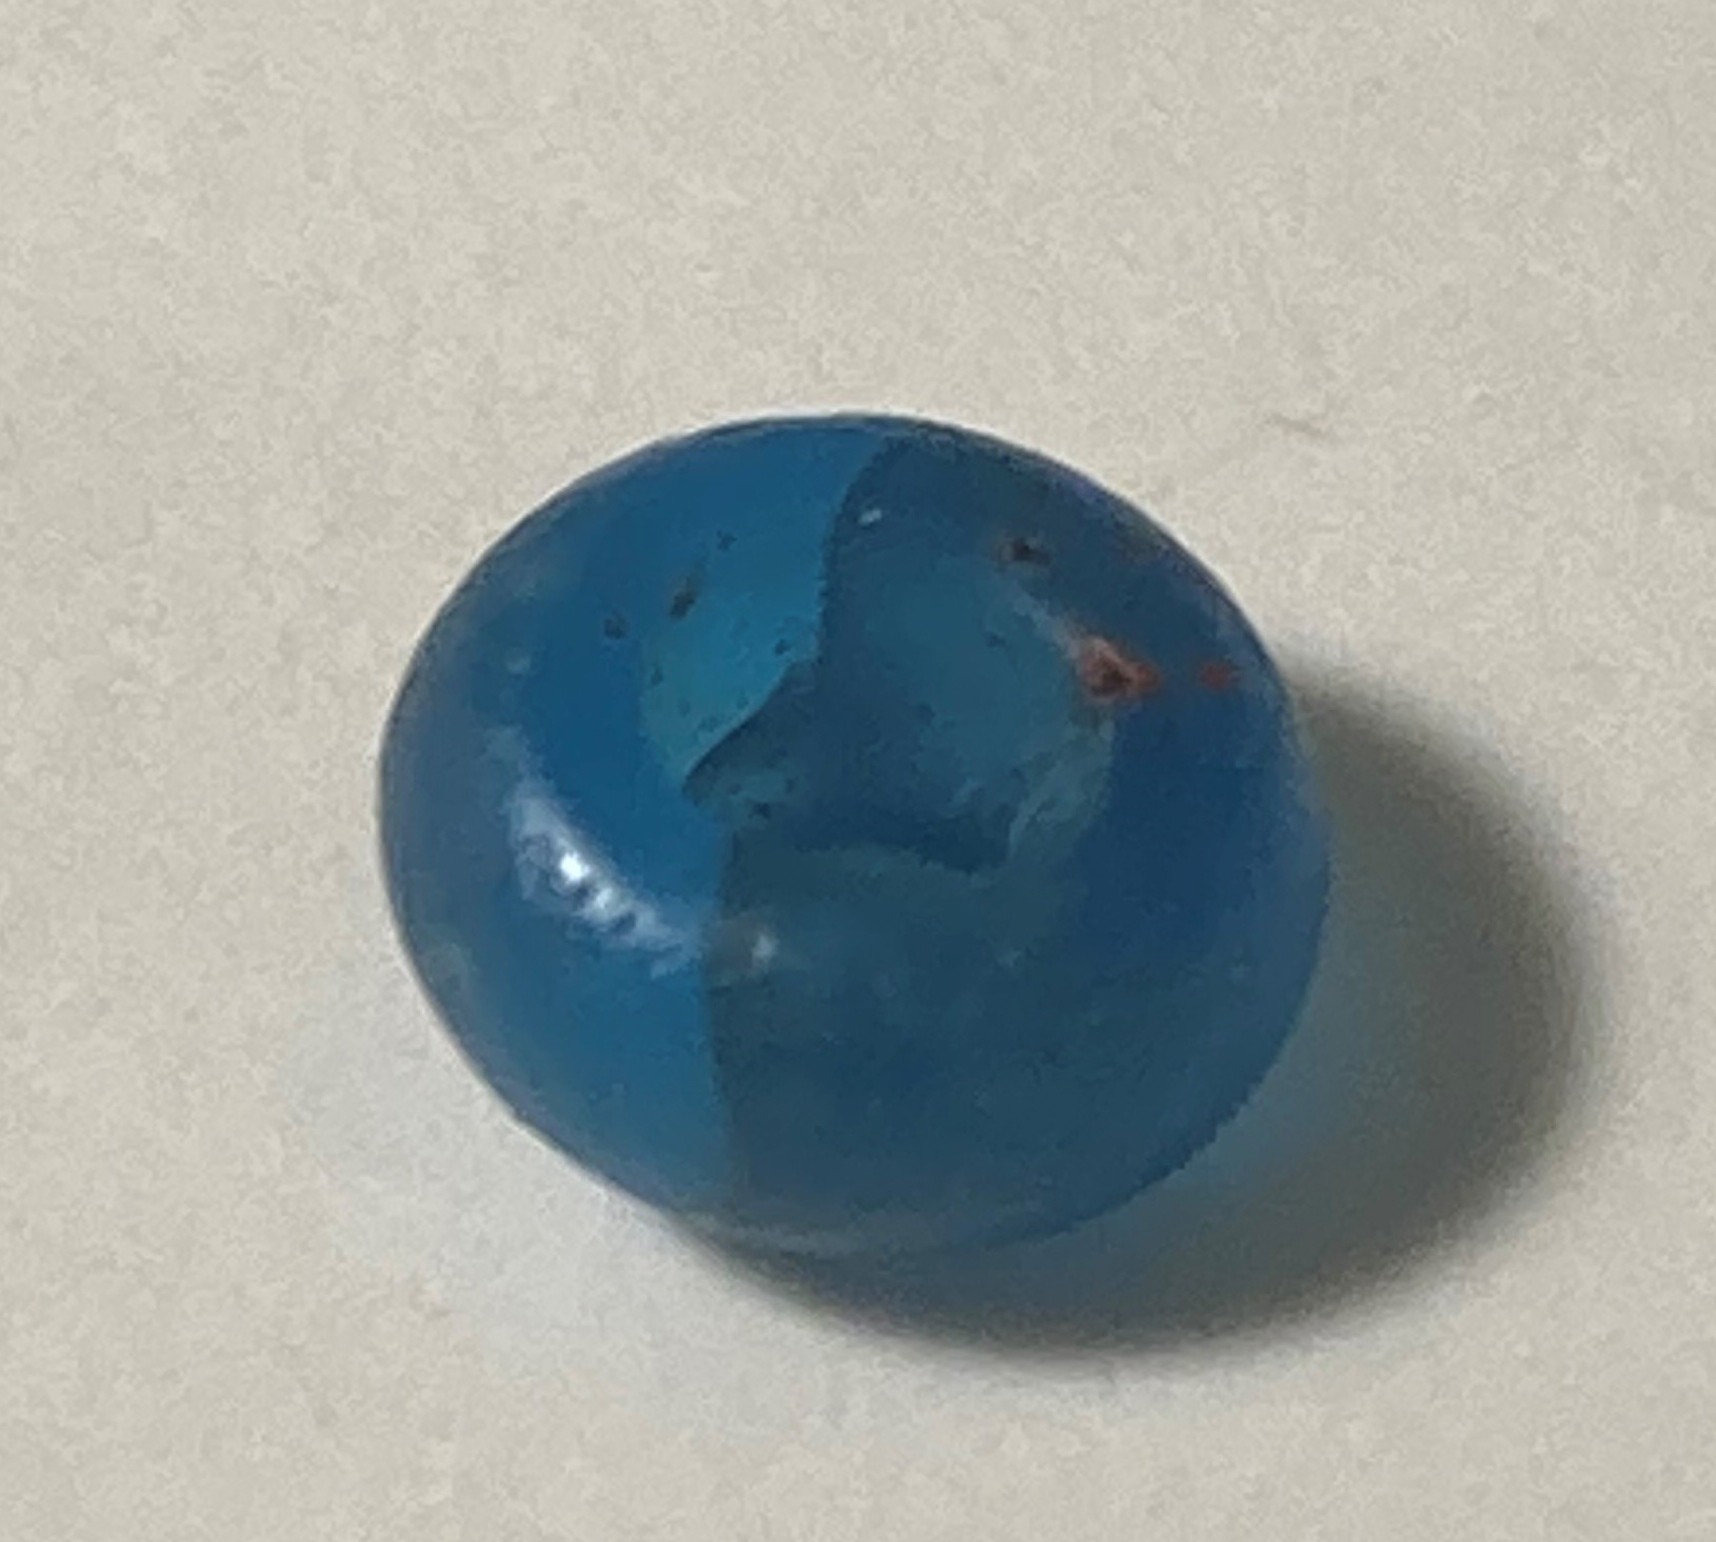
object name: bead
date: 701-1200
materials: glass, stone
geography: iran